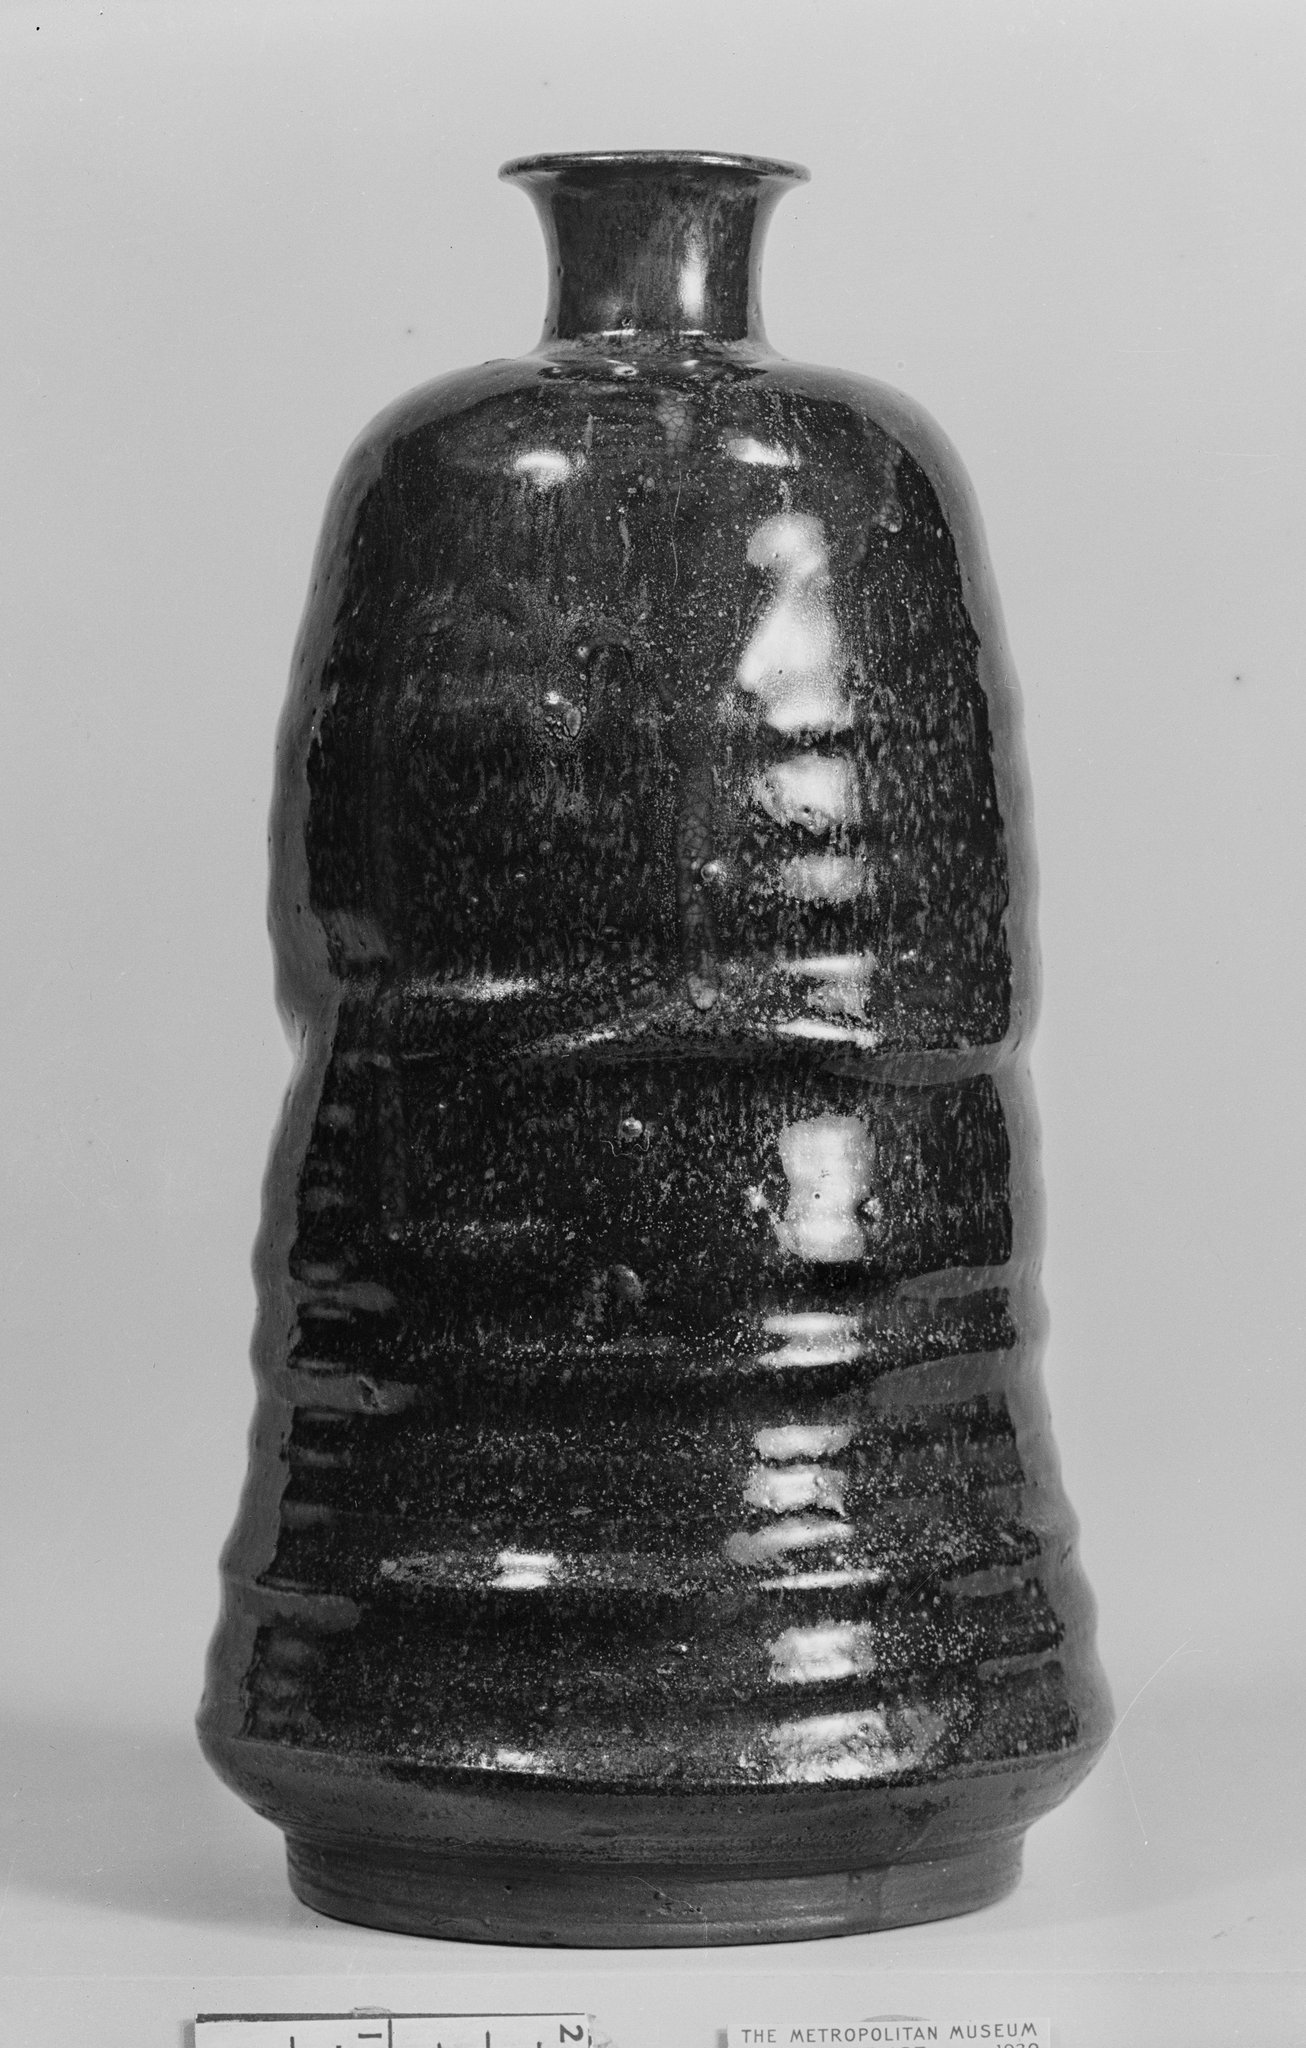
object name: bottle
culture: japanese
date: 1500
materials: clay, glaze